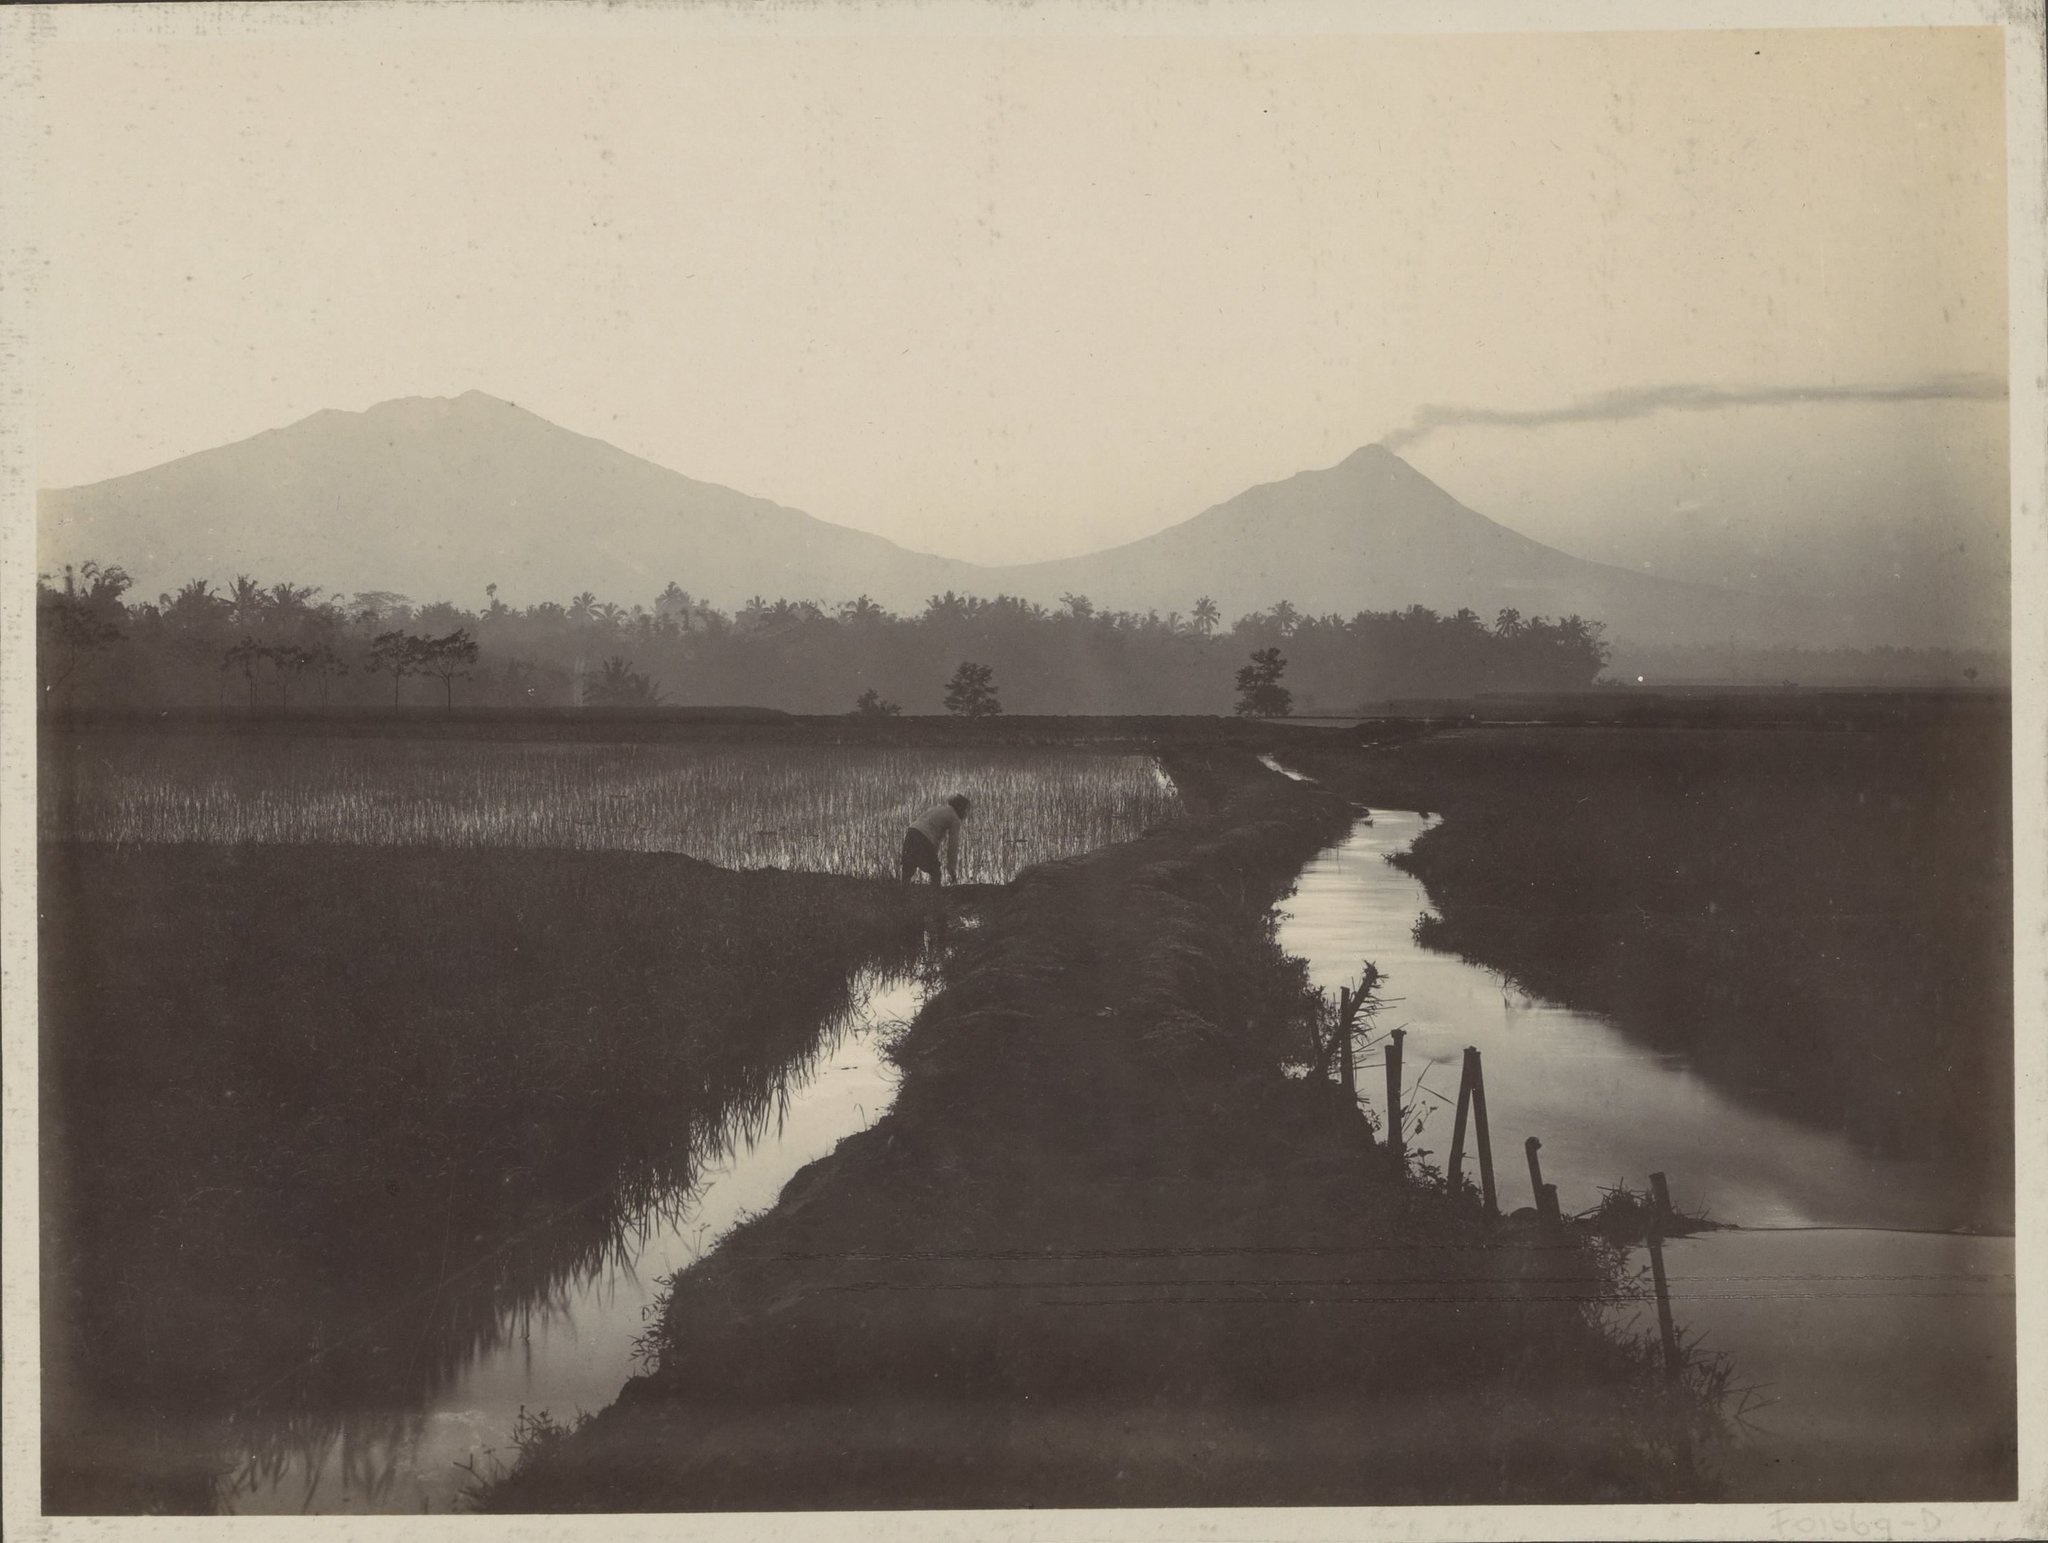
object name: photograph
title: Man werkend op het land aan de voet van een rokende vulkaan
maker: onnes kurkdjian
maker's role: fotograaf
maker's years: 1851-1903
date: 1912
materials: paper, photographic support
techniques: gelatin silver print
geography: dutch east indies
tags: field filled with a crop, volcano, dutch east indies, the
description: Onderdeel van Reisalbum met veertig foto's van Nederlands-Indië.